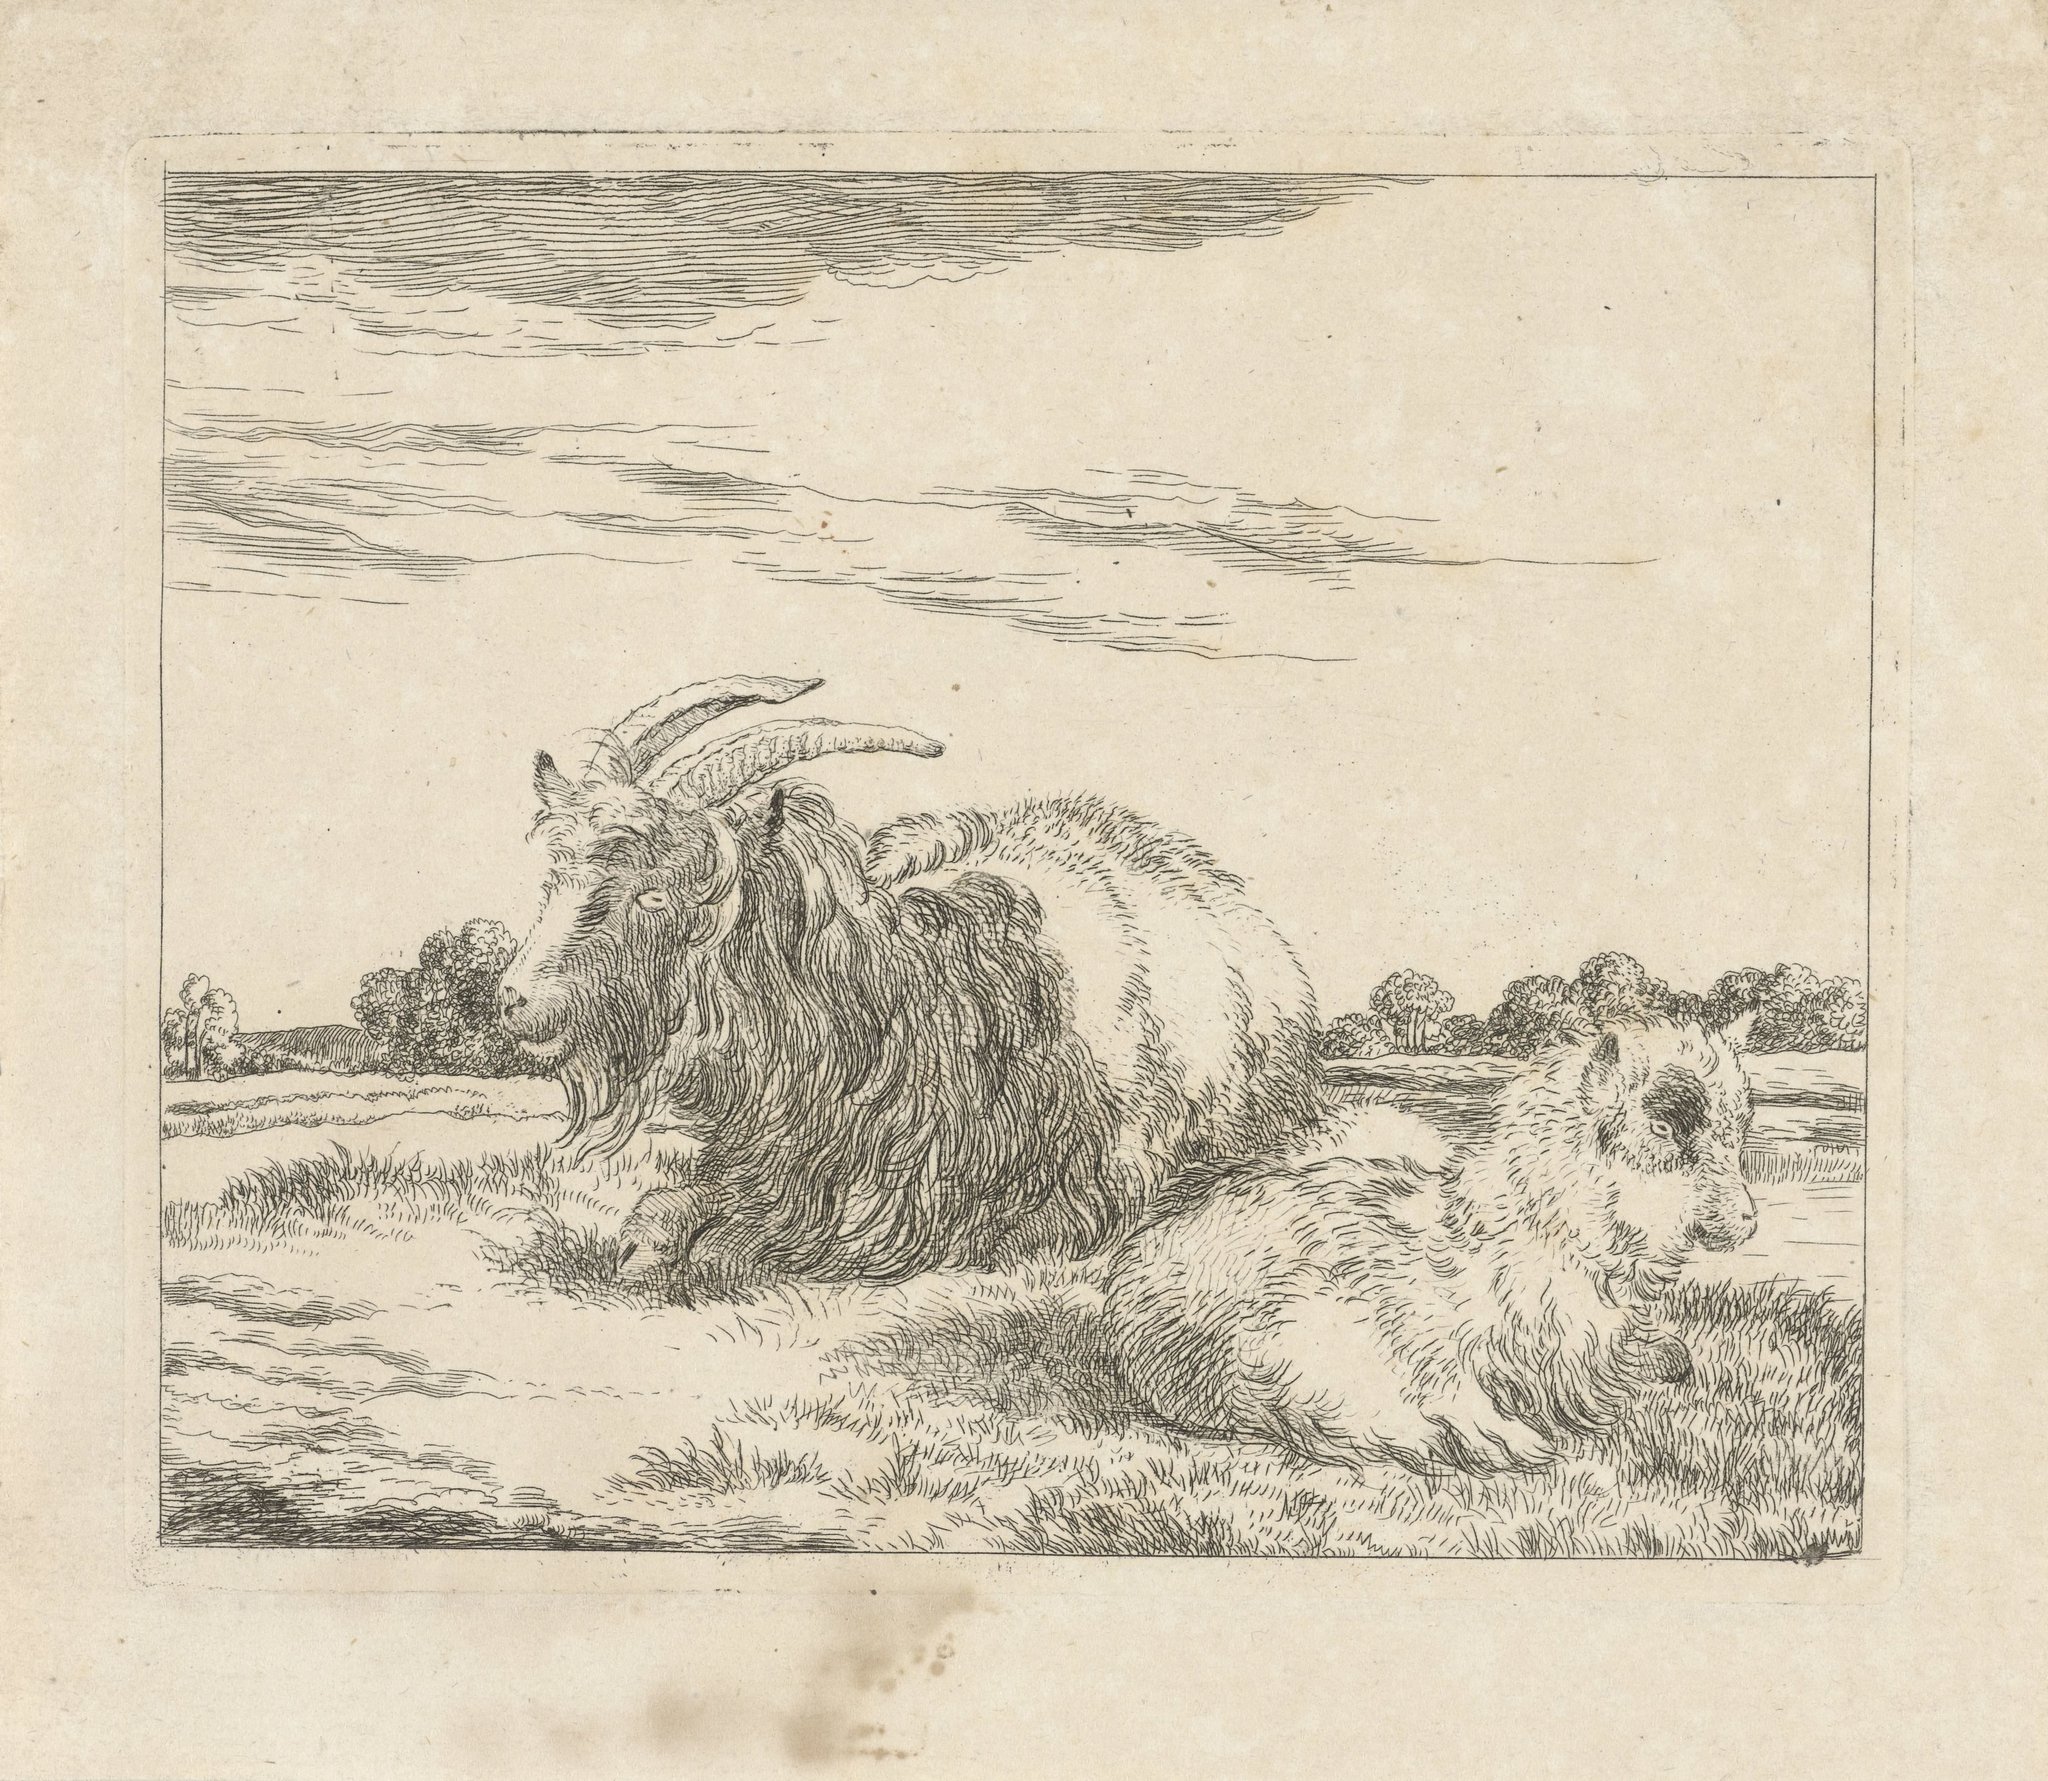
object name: print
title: Liggende bok en geitje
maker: pieter gerardus van os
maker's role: draughtsman, painter, print maker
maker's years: 1776-1839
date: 1791-1839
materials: paper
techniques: etching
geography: netherlands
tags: goat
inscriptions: collector's mark: Lugt 2228